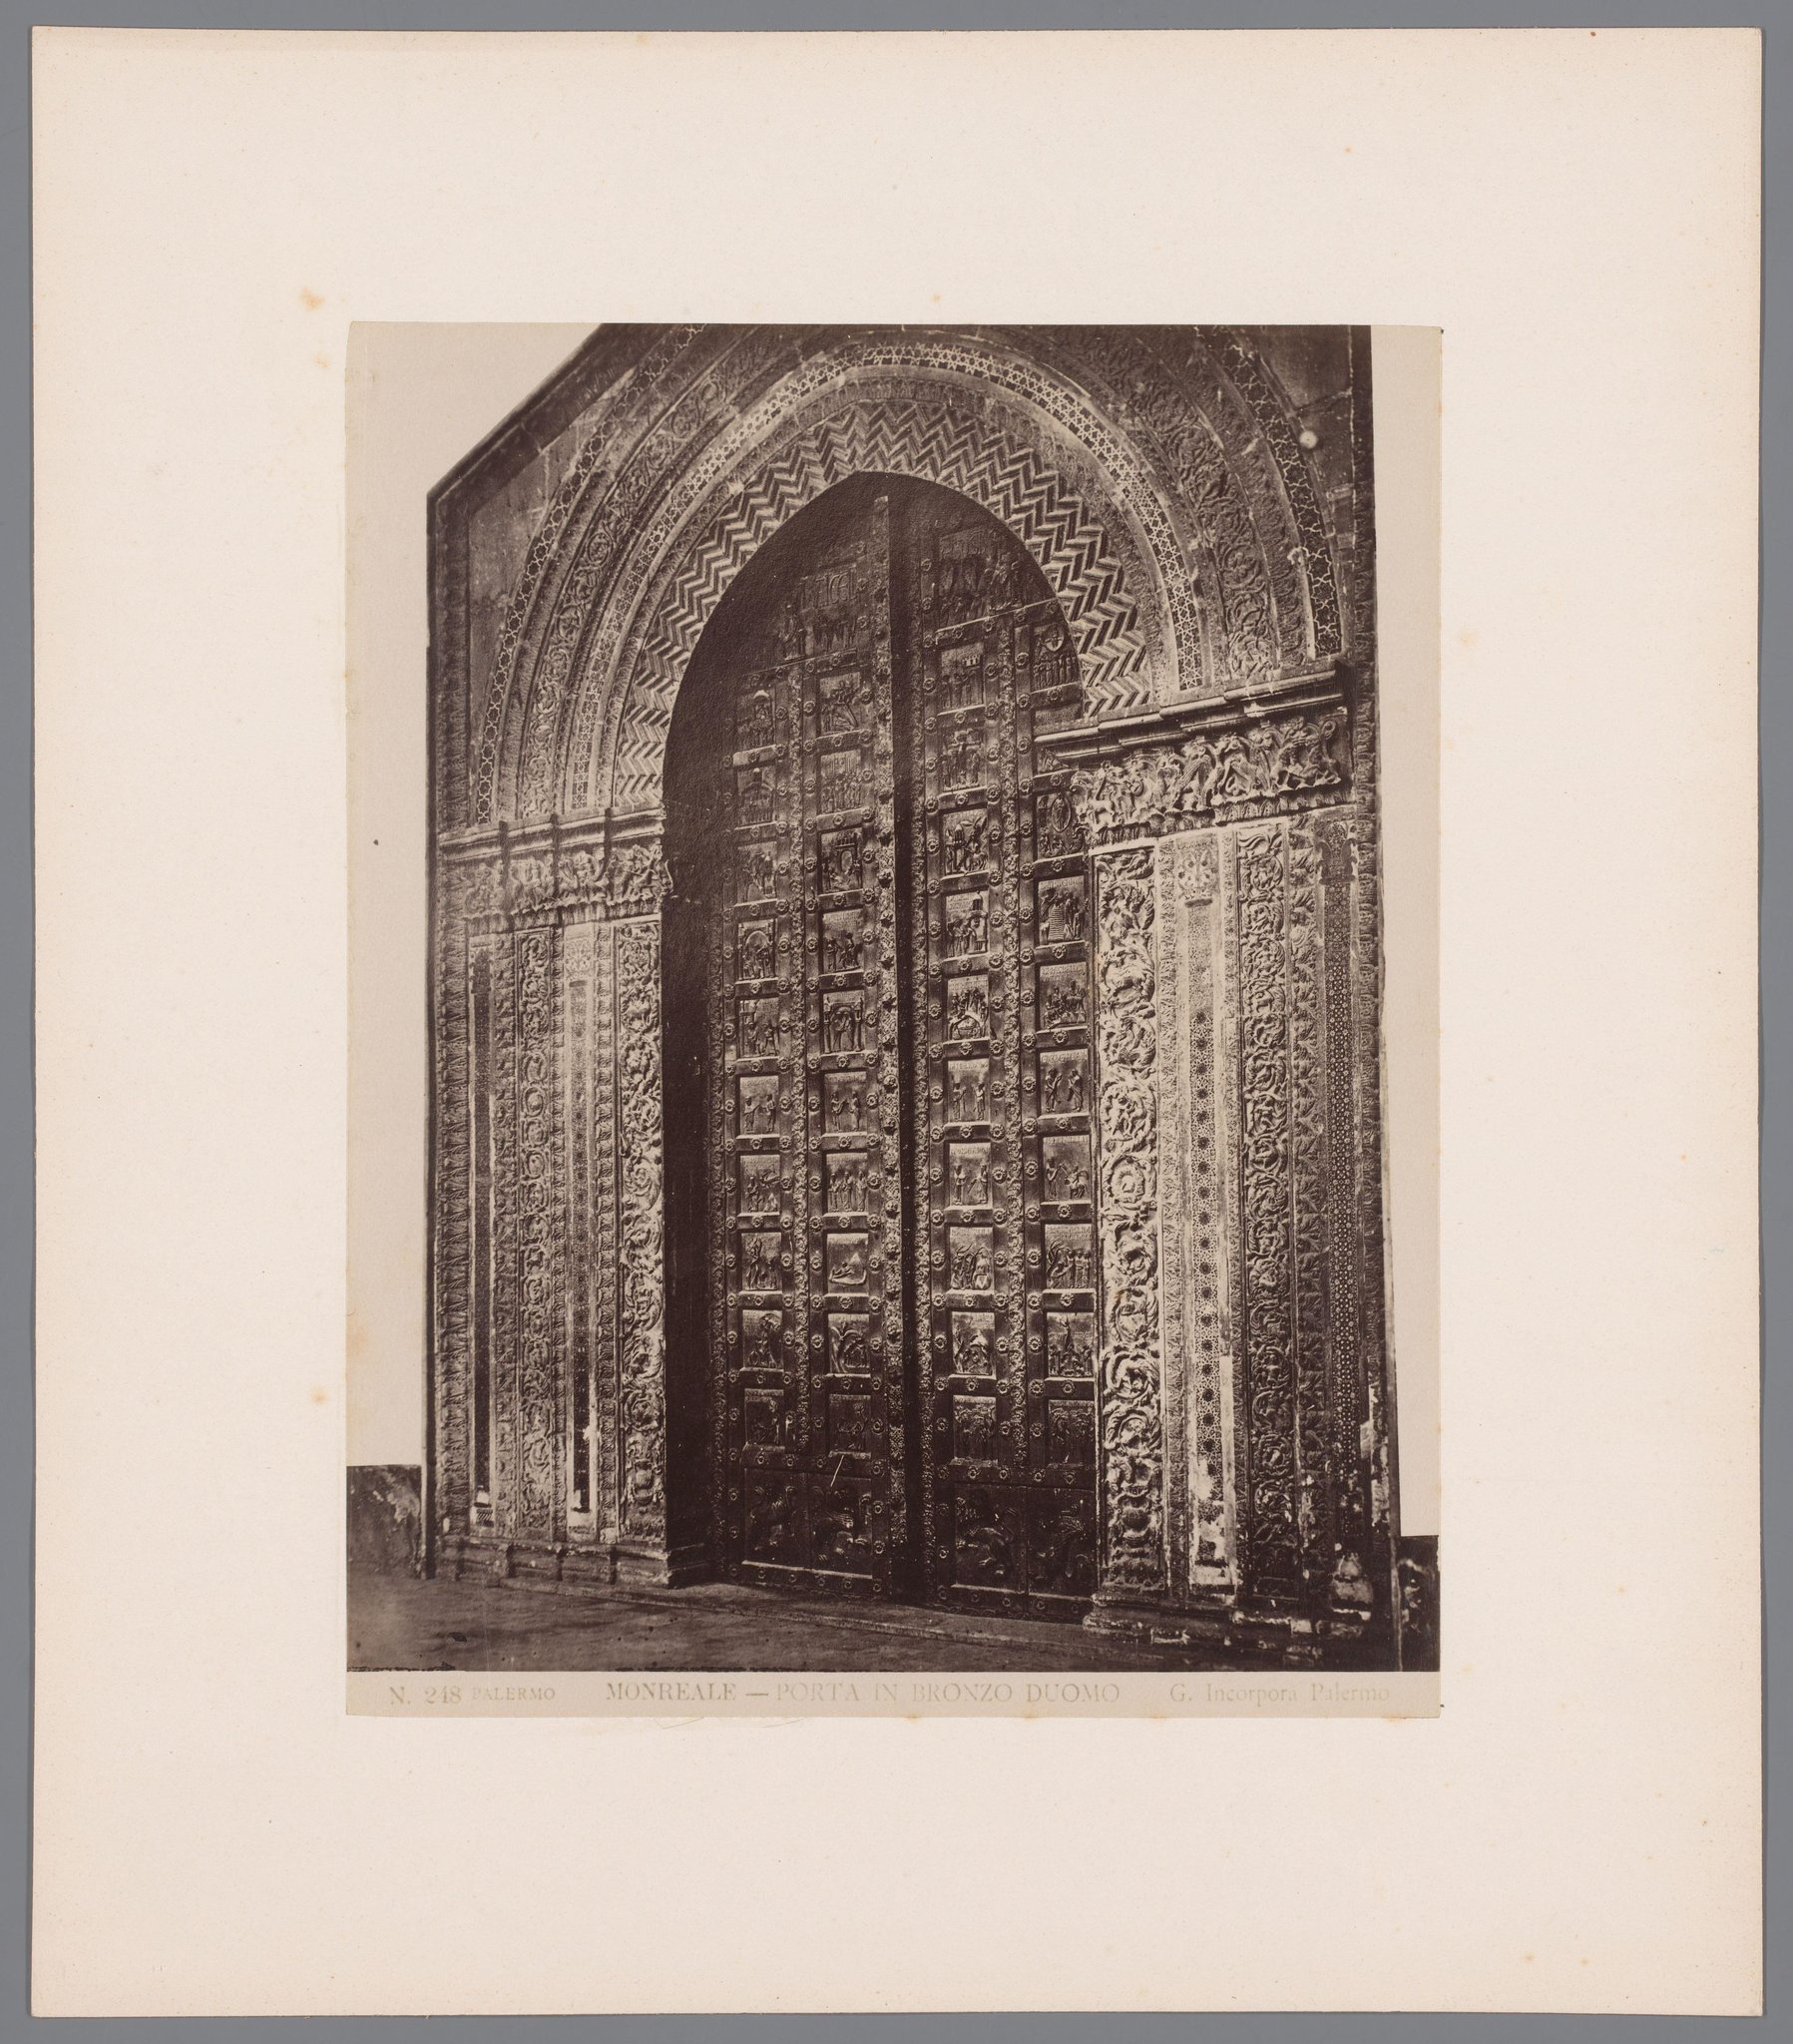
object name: photograph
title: Monreale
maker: giuseppe incorpora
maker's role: fotograaf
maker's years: 1834-1914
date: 1856-1914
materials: cardboard, paper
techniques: albumen print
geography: monreale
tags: parts of church exterior and annexes: portal, gate, entrance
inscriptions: number: ‘N. 248’